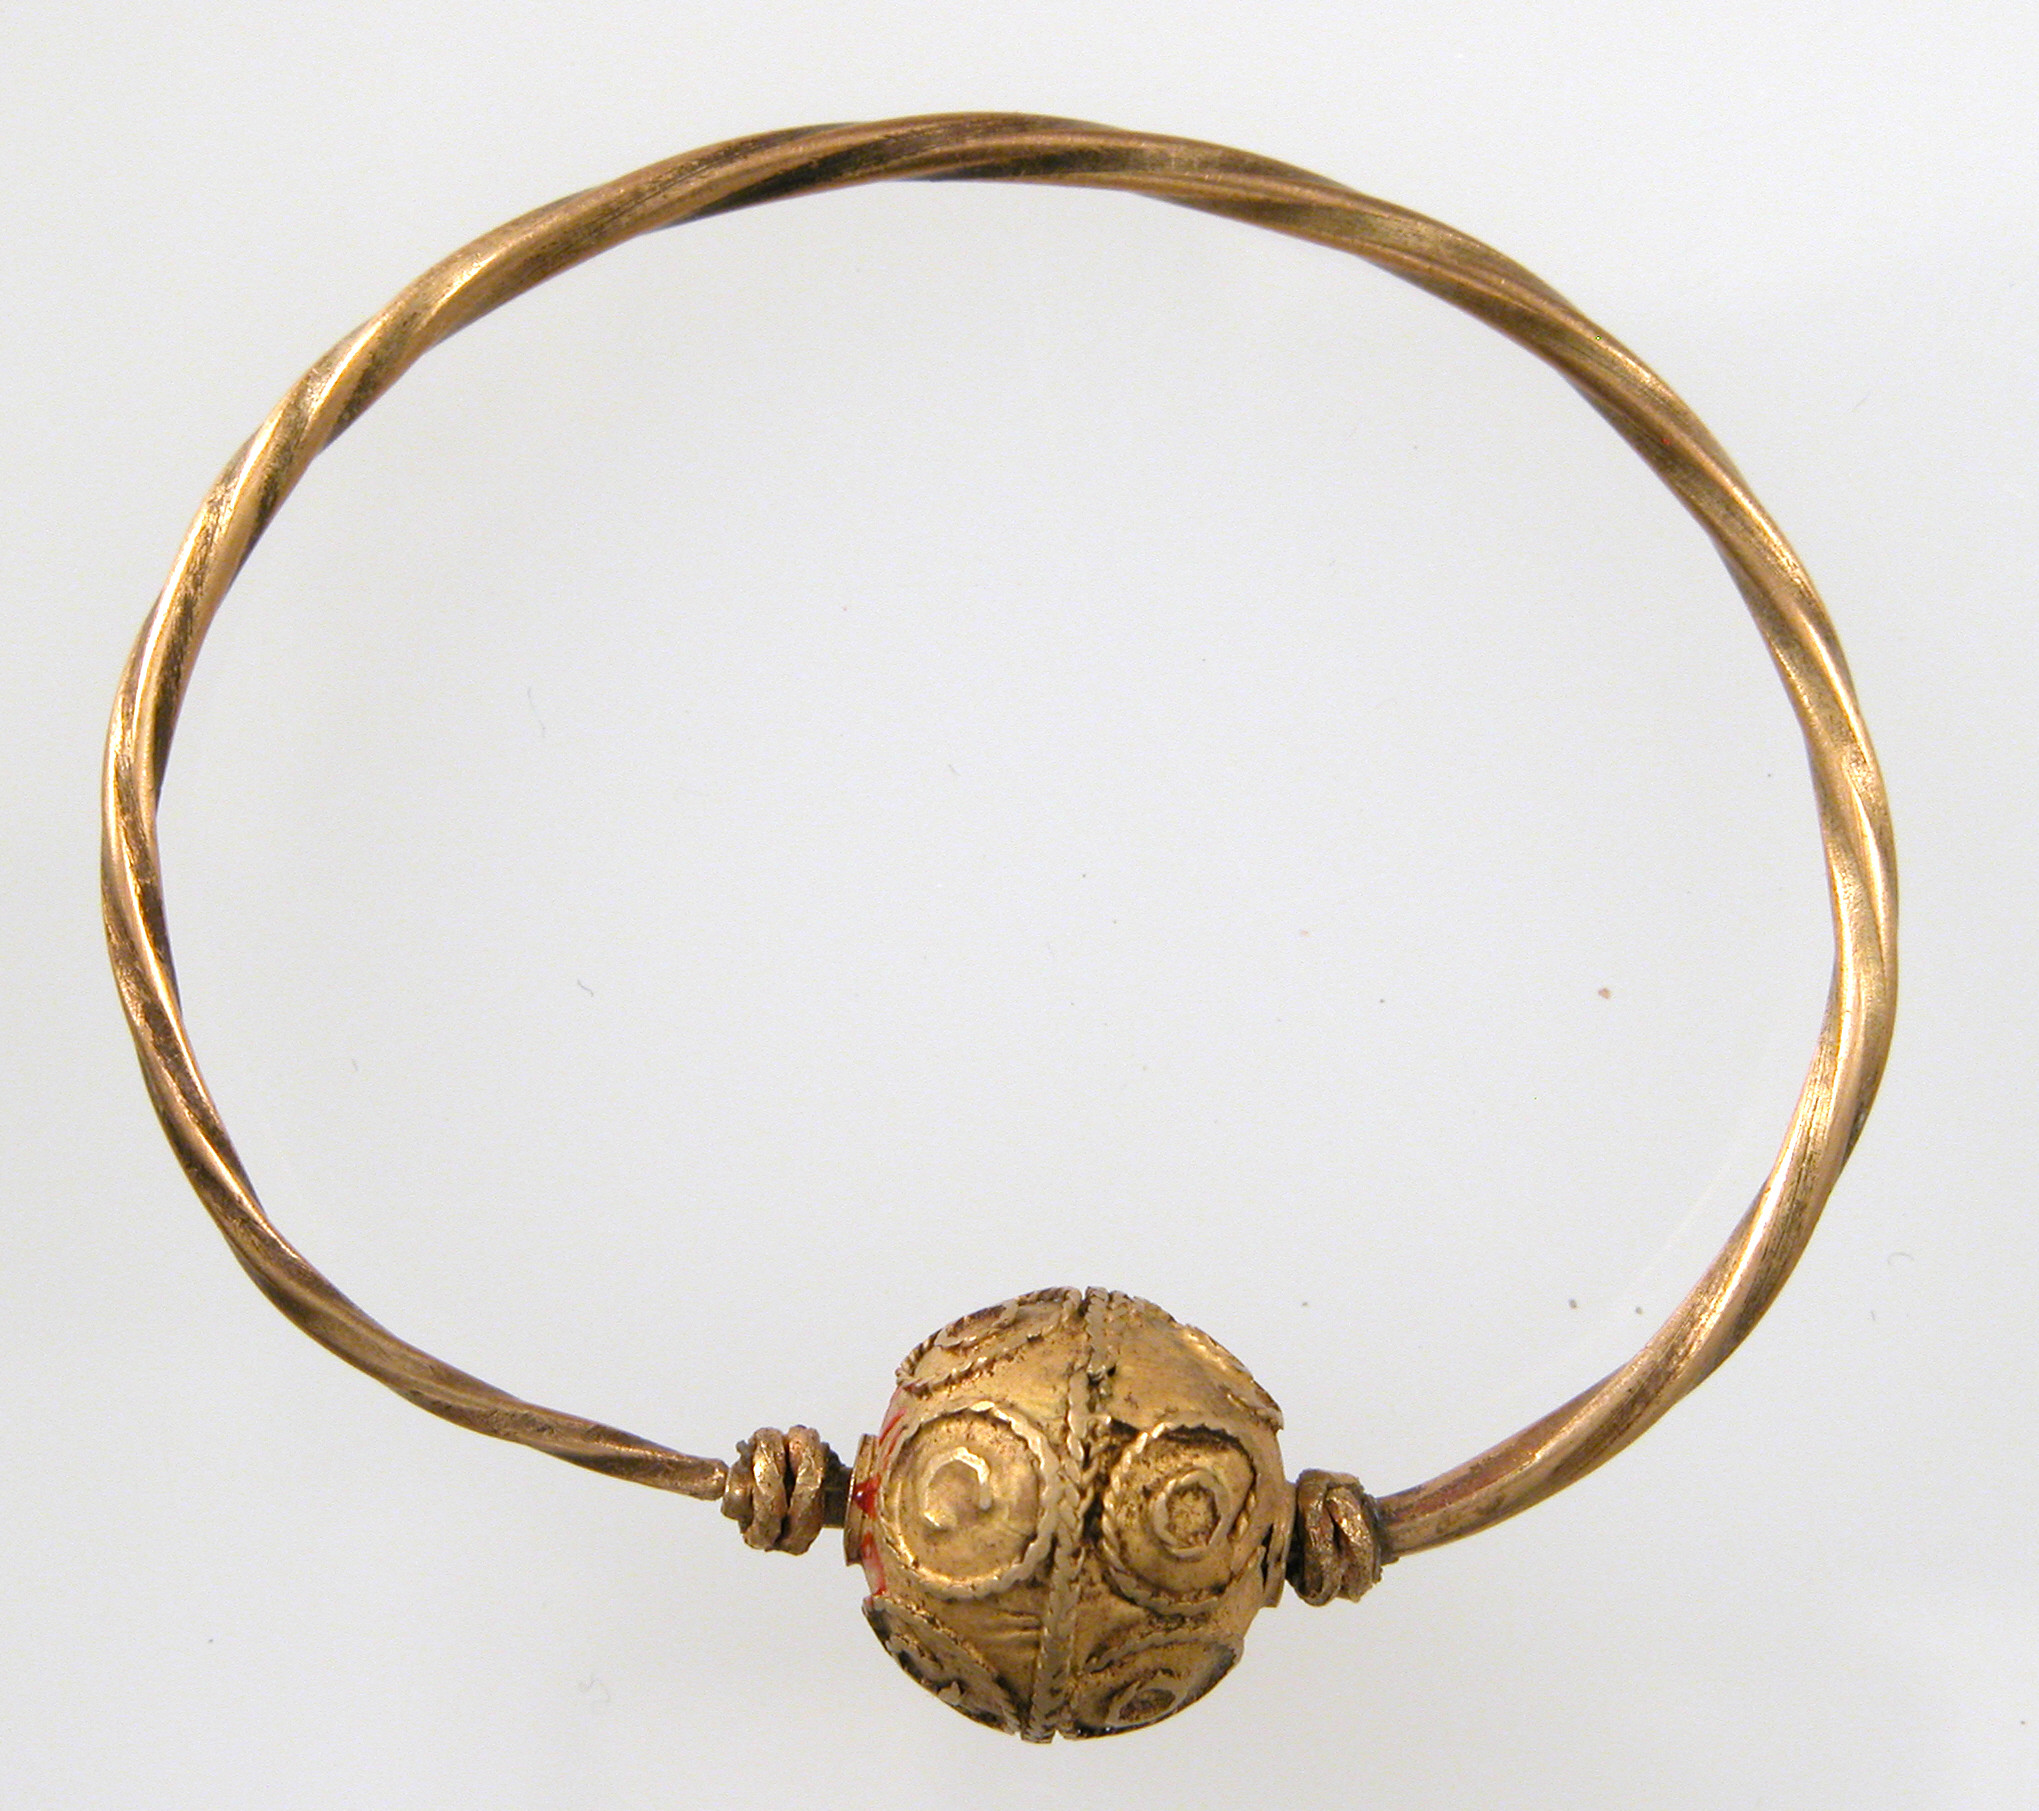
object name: earring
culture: langobardic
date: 501-700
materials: gold